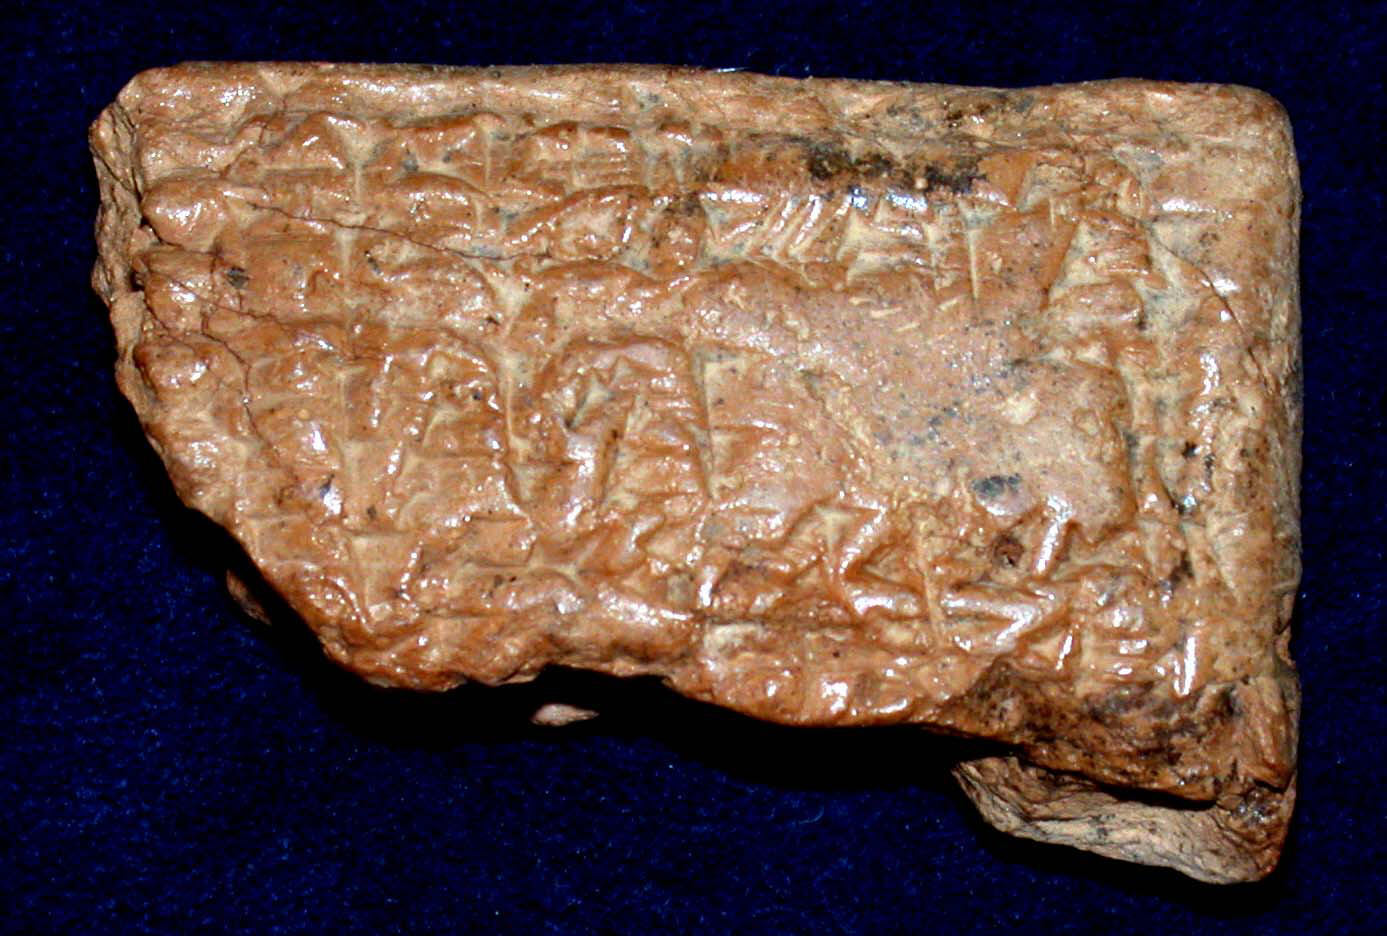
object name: cuneiform tablet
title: Cuneiform tablet: fragment, Ebabbar archive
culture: babylonian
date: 633 BCE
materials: clay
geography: mesopotamia